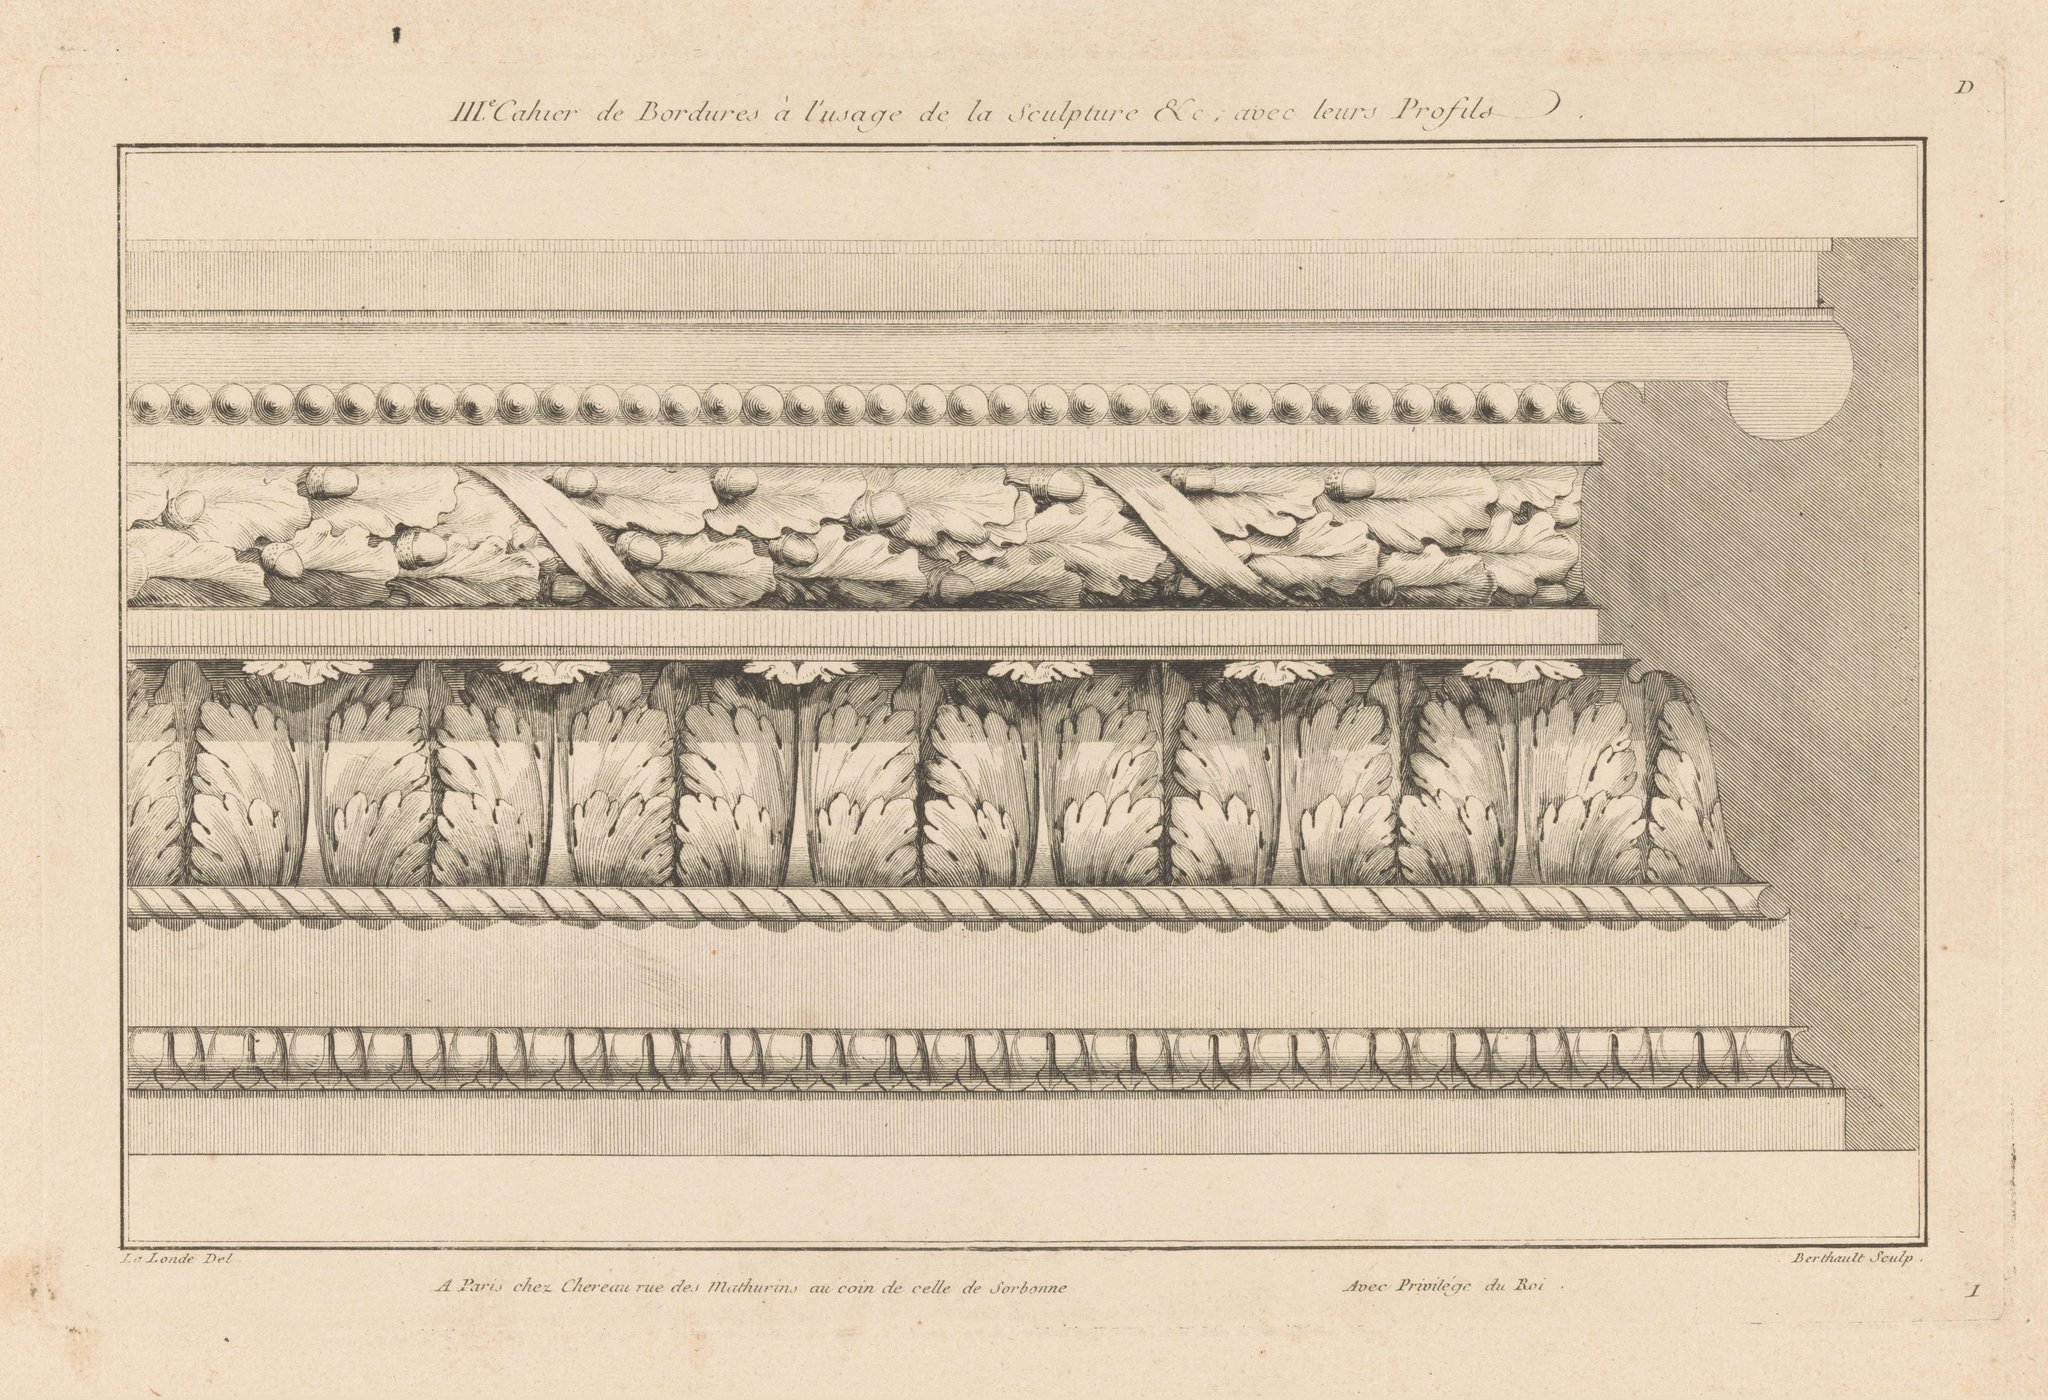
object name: ornament print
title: D IIIe Cahier de Bordures à l'usage de la Sculpture &c, avec leurs Profils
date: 1784-1785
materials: paper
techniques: engraving, etching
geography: paris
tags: ornaments ~ art (+ framing decorations)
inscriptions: collector's mark: Lugt 2760, collector's mark: Lugt 2228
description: Een geornamenteerde lijst met eikenbladeren en acanthusbladeren.